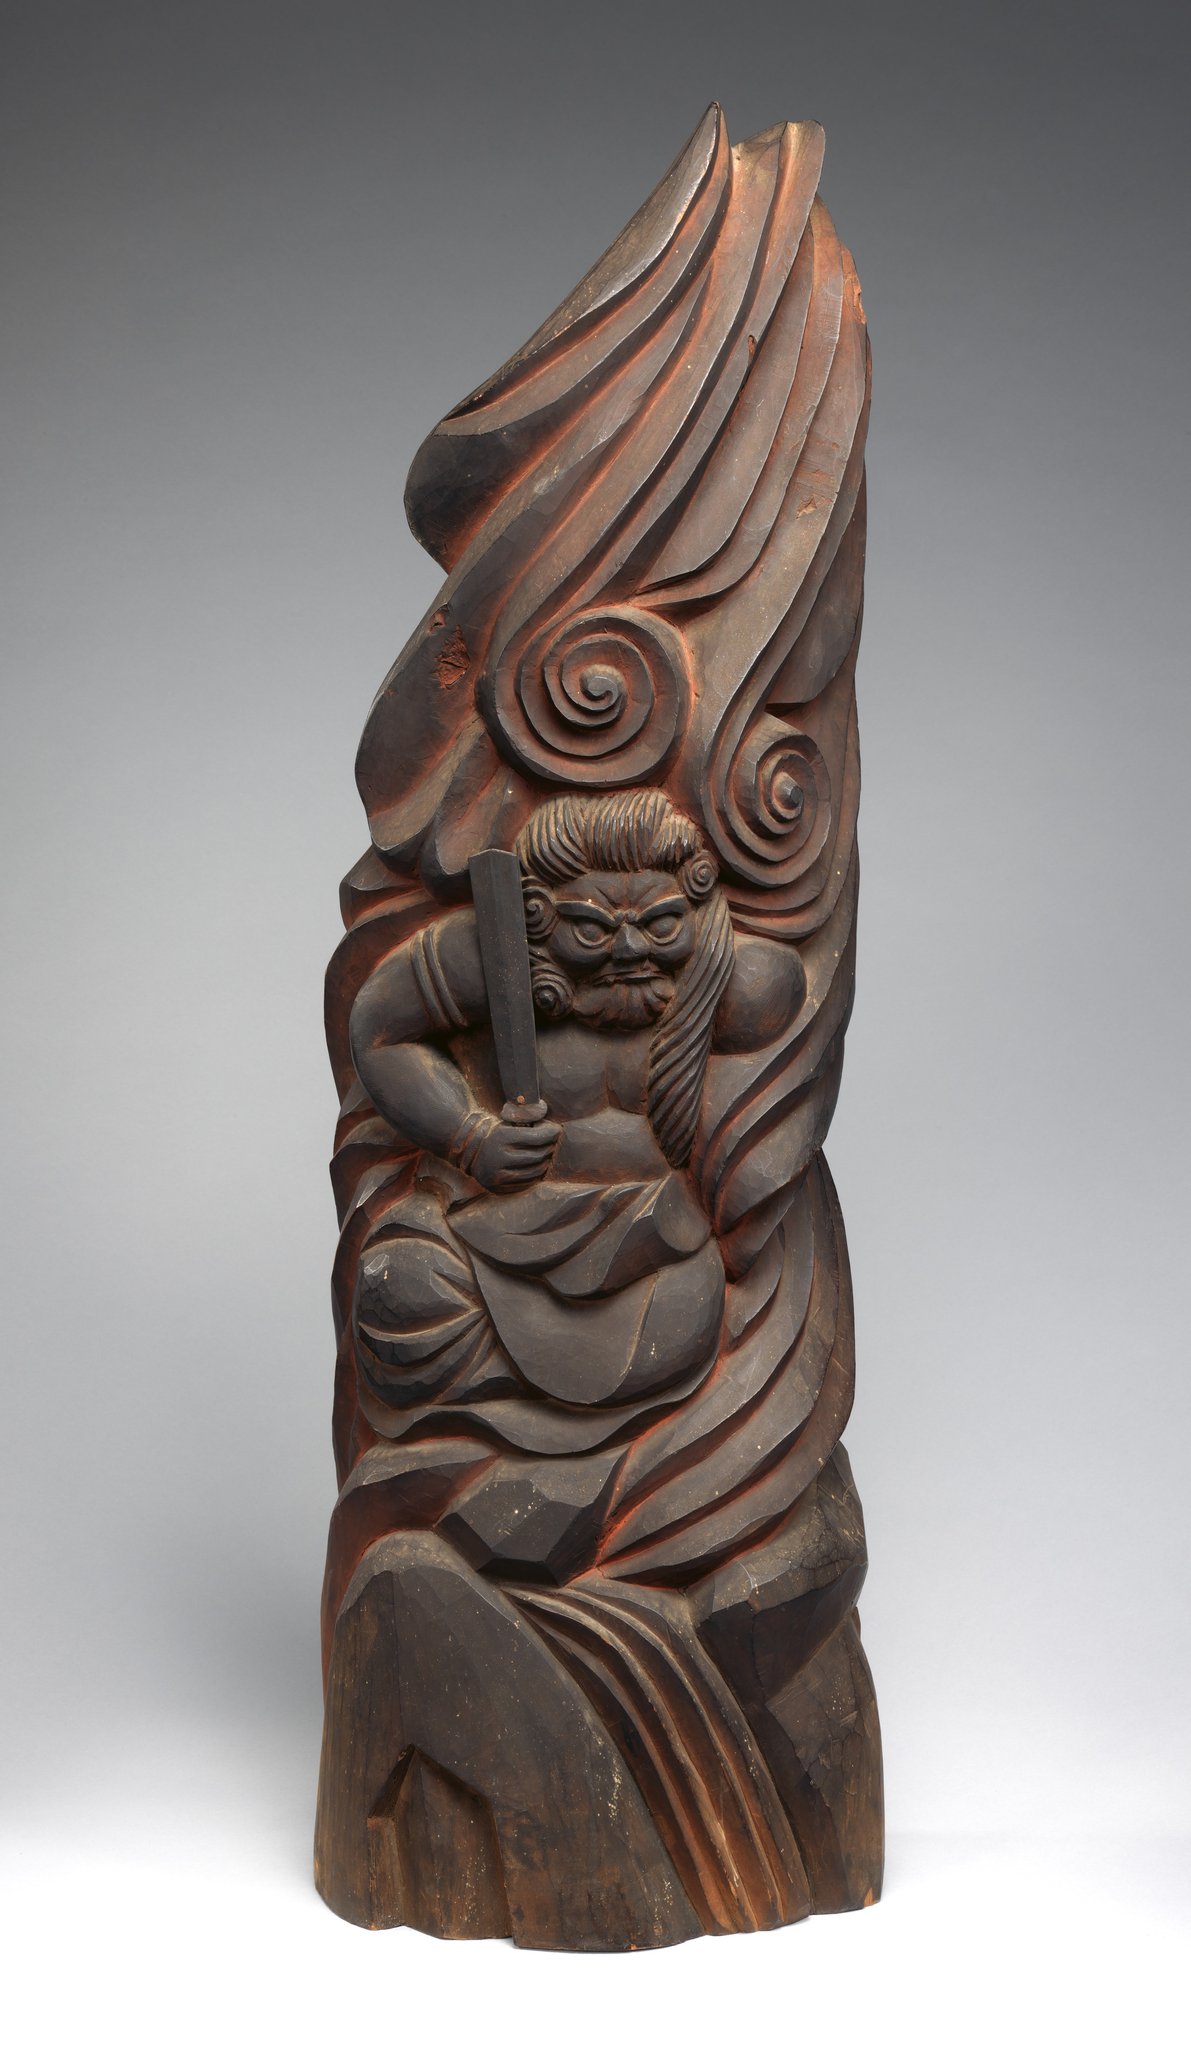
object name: sculpture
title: Fudō Myōō (Achala Vidyaraja), The Immovable Wisdom King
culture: japanese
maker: mokujiki shōnin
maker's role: artist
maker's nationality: japanese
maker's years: 1718-1810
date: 1805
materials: wood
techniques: carving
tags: swords,men,buddhism